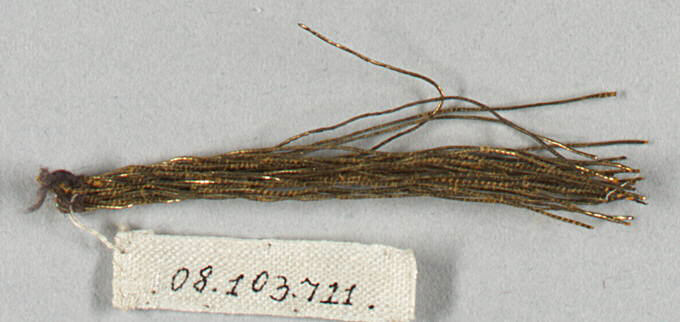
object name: thread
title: Tinsel and metal thread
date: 1601-1800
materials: metal thread